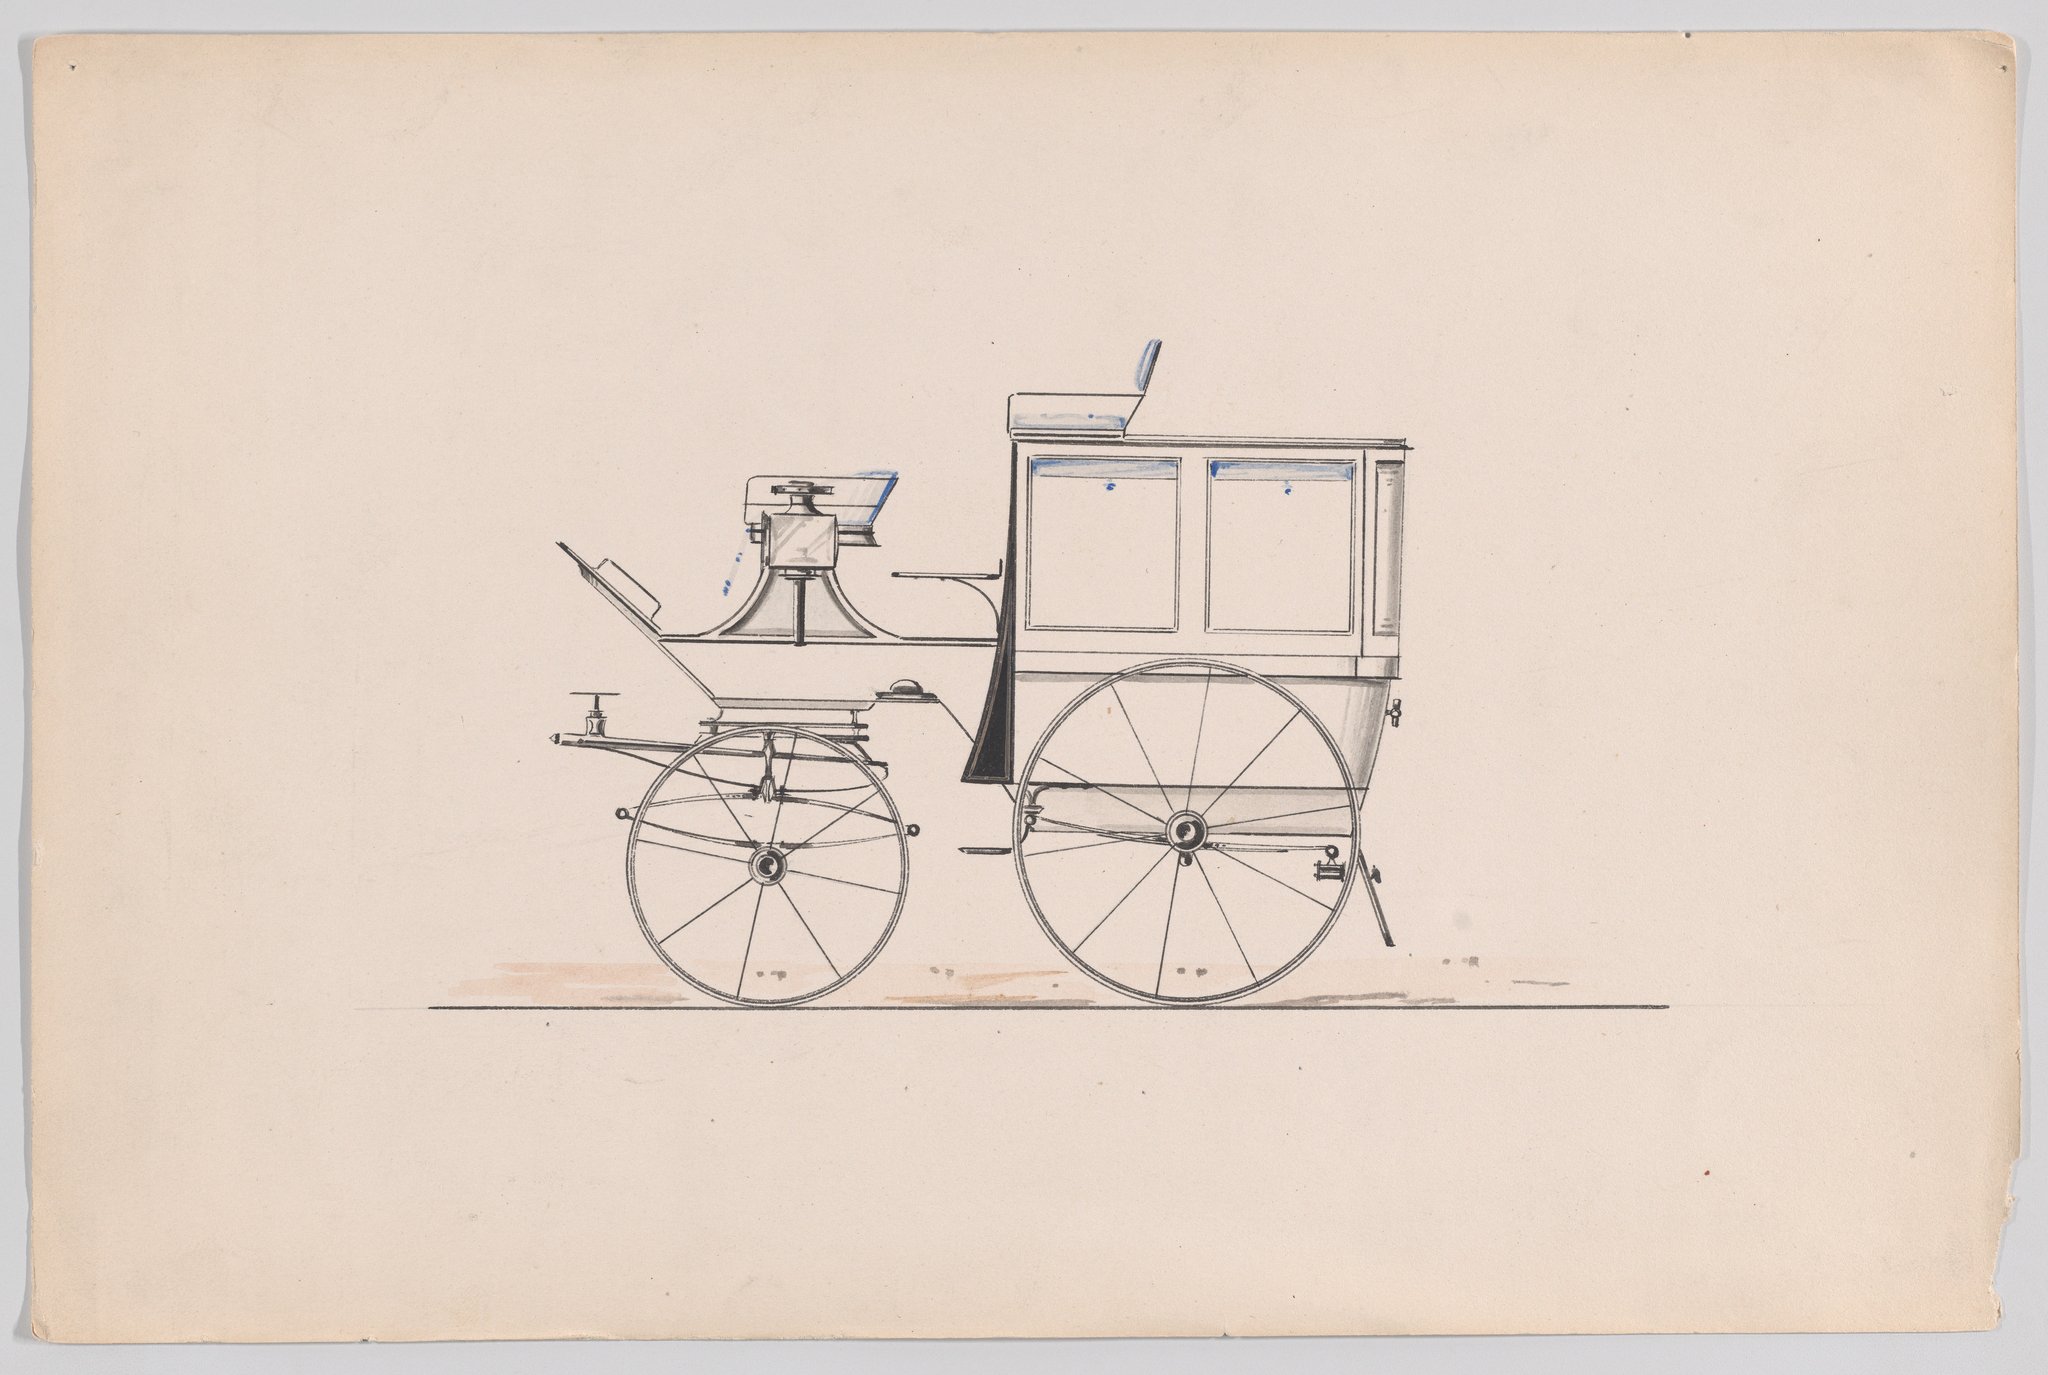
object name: drawing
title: Design for Opera Bus (French?)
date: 1880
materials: gouache, ink, watercolor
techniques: pen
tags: carriages